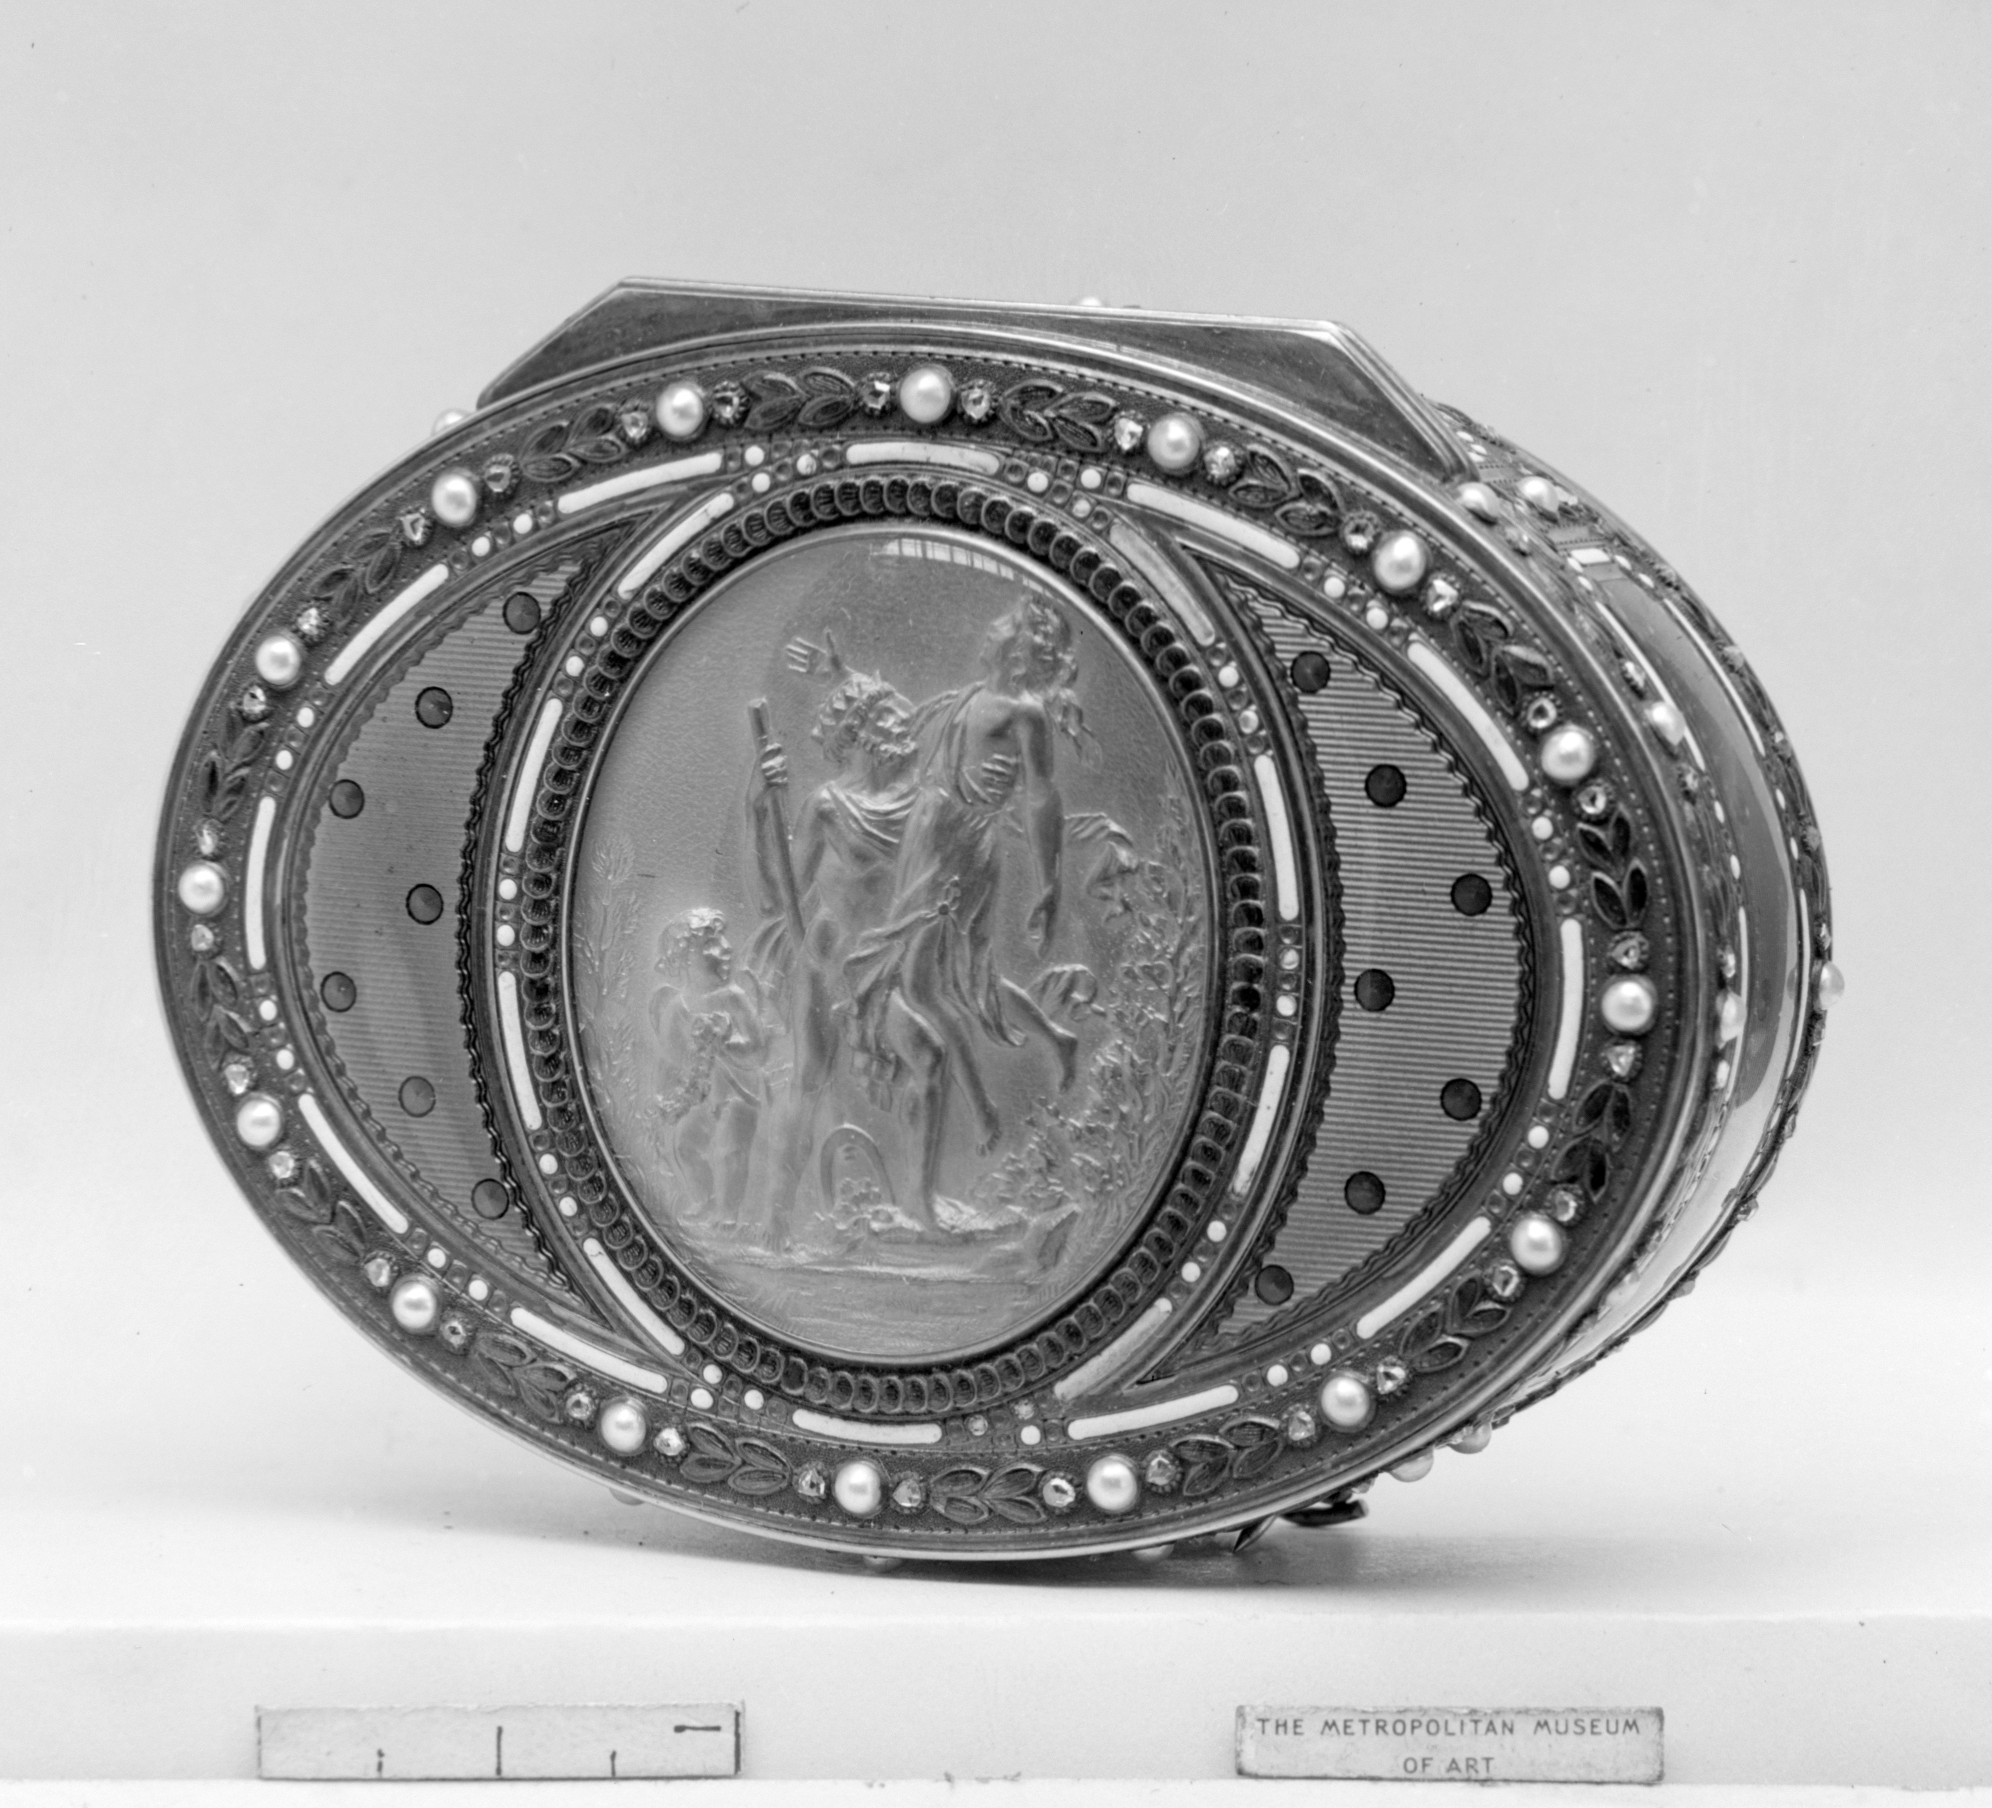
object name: snuffbox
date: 1801-1900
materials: diamond, enamel, gold, pearl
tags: men,women